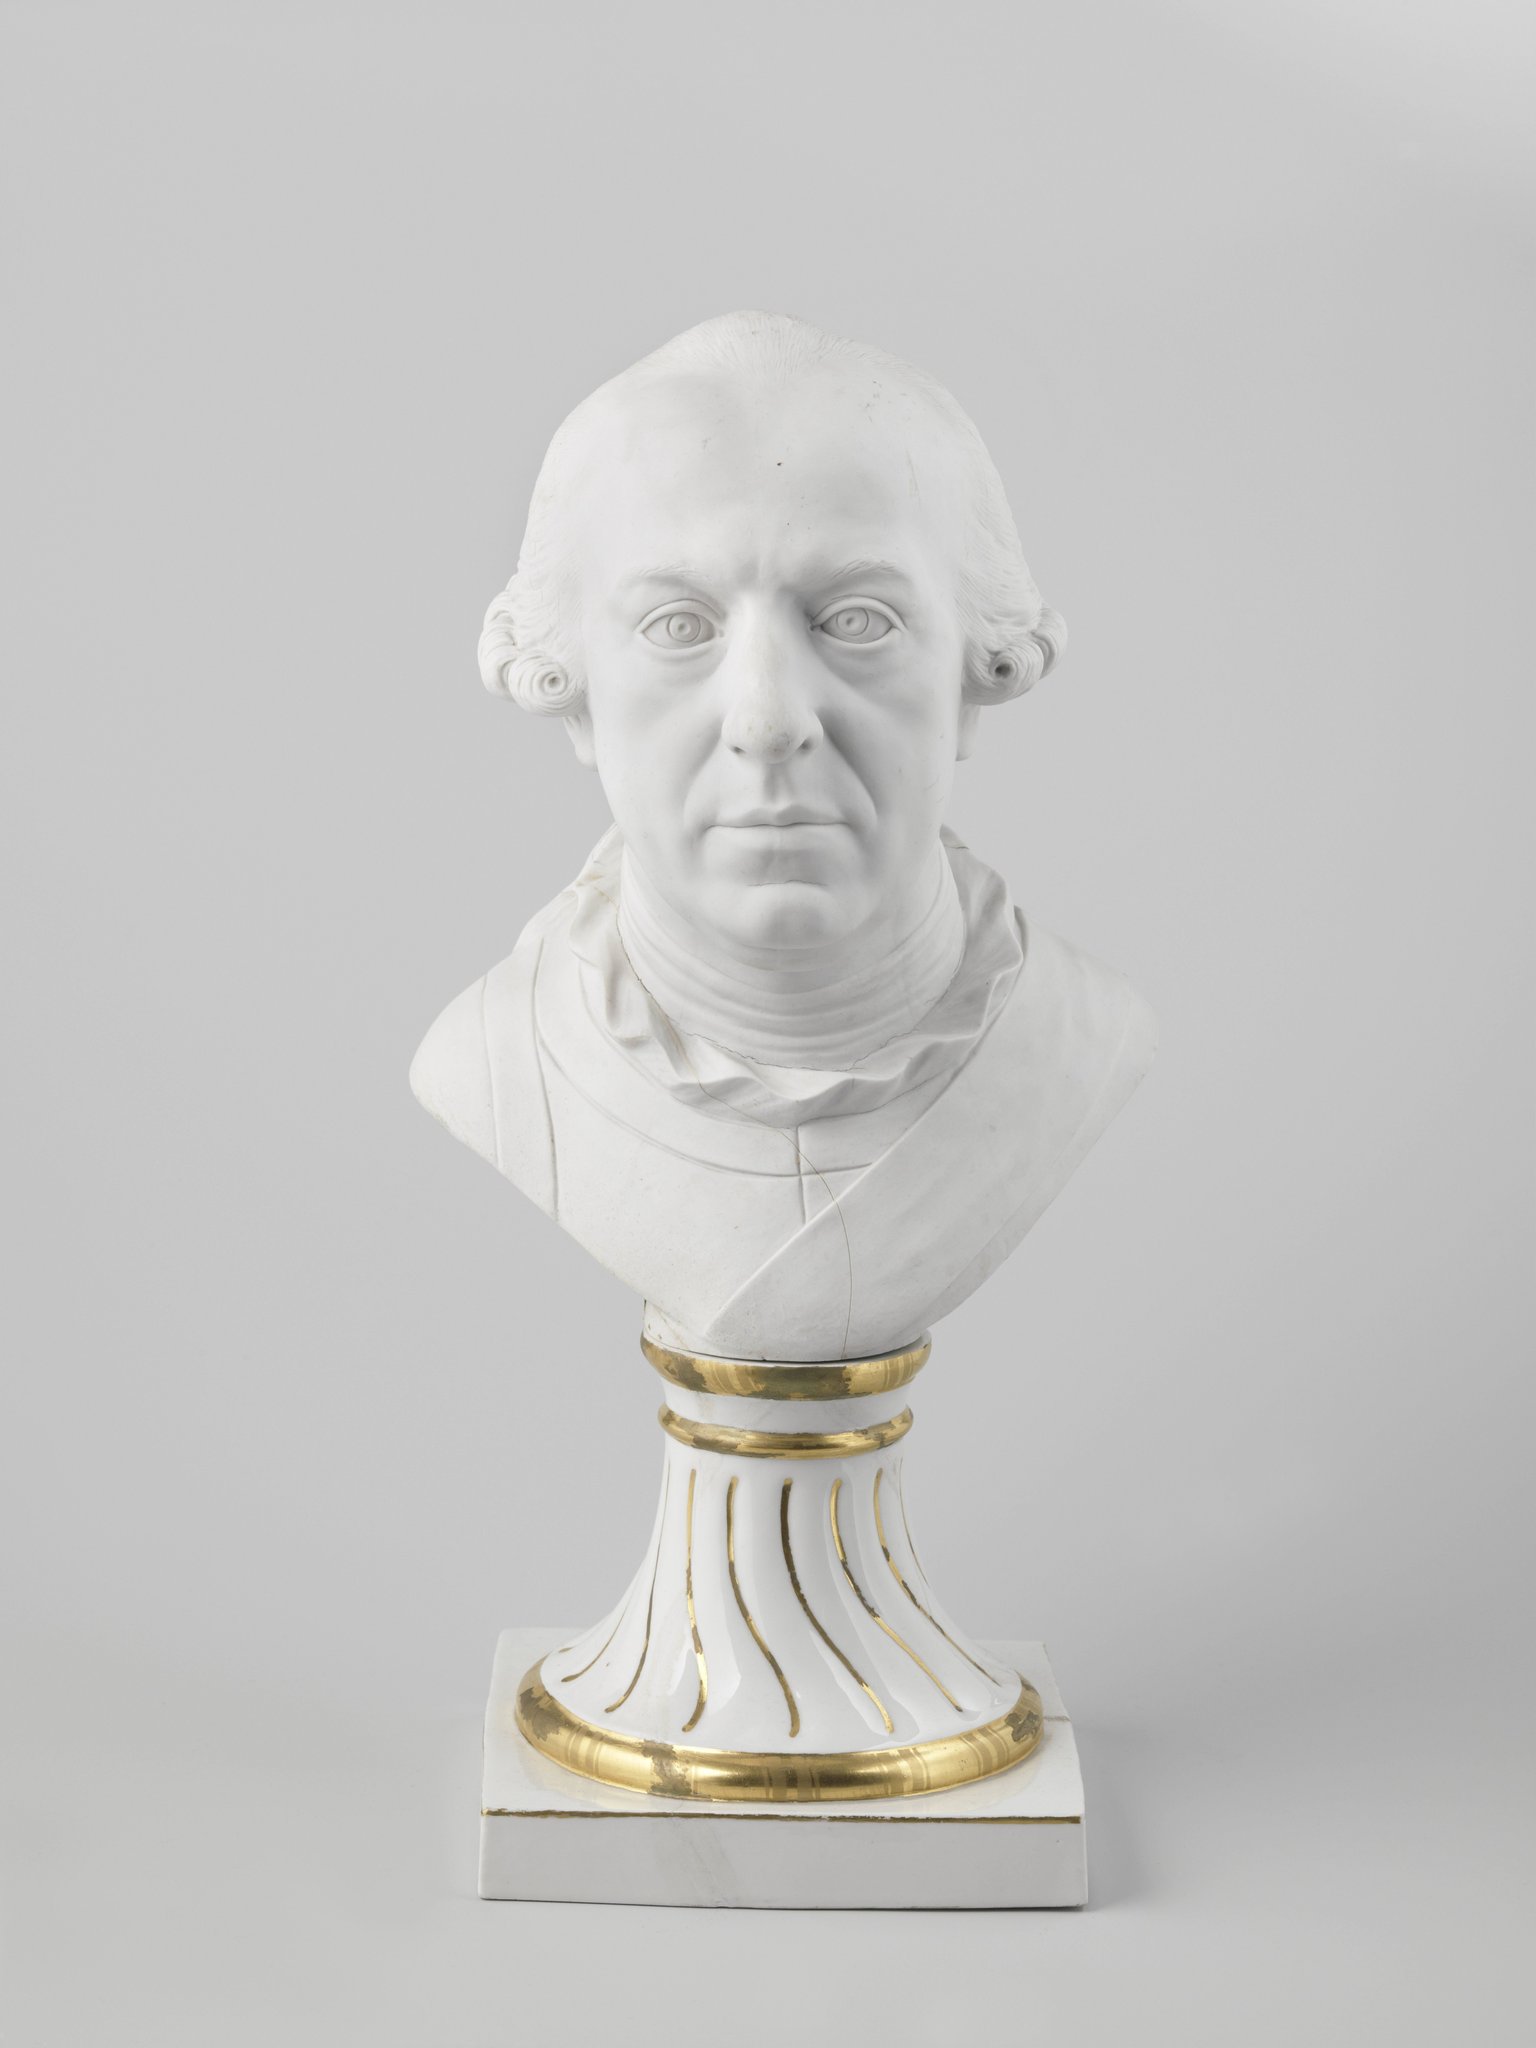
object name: bust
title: Bust of Carl Wilhelm Ferdinand, prince of Braunschweig-Lüneburg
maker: jean jacques desoches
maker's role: porseleinmodelleur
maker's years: -1774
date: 1772-1780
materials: glaze, gold, paint, porcelain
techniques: firing, forming, gilding, relief, vitrification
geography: furstenberg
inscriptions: mark: ‘F/ R’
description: Bust on base of Karl Wilhelm Ferdinand, Duke of Brunswick and Lüneburg. Biscuit porcelain. Fürstenberg, c. 1772 - 1780. Model by Jean Jacques Desoches. Given by A. Oltmans, c. 1840.